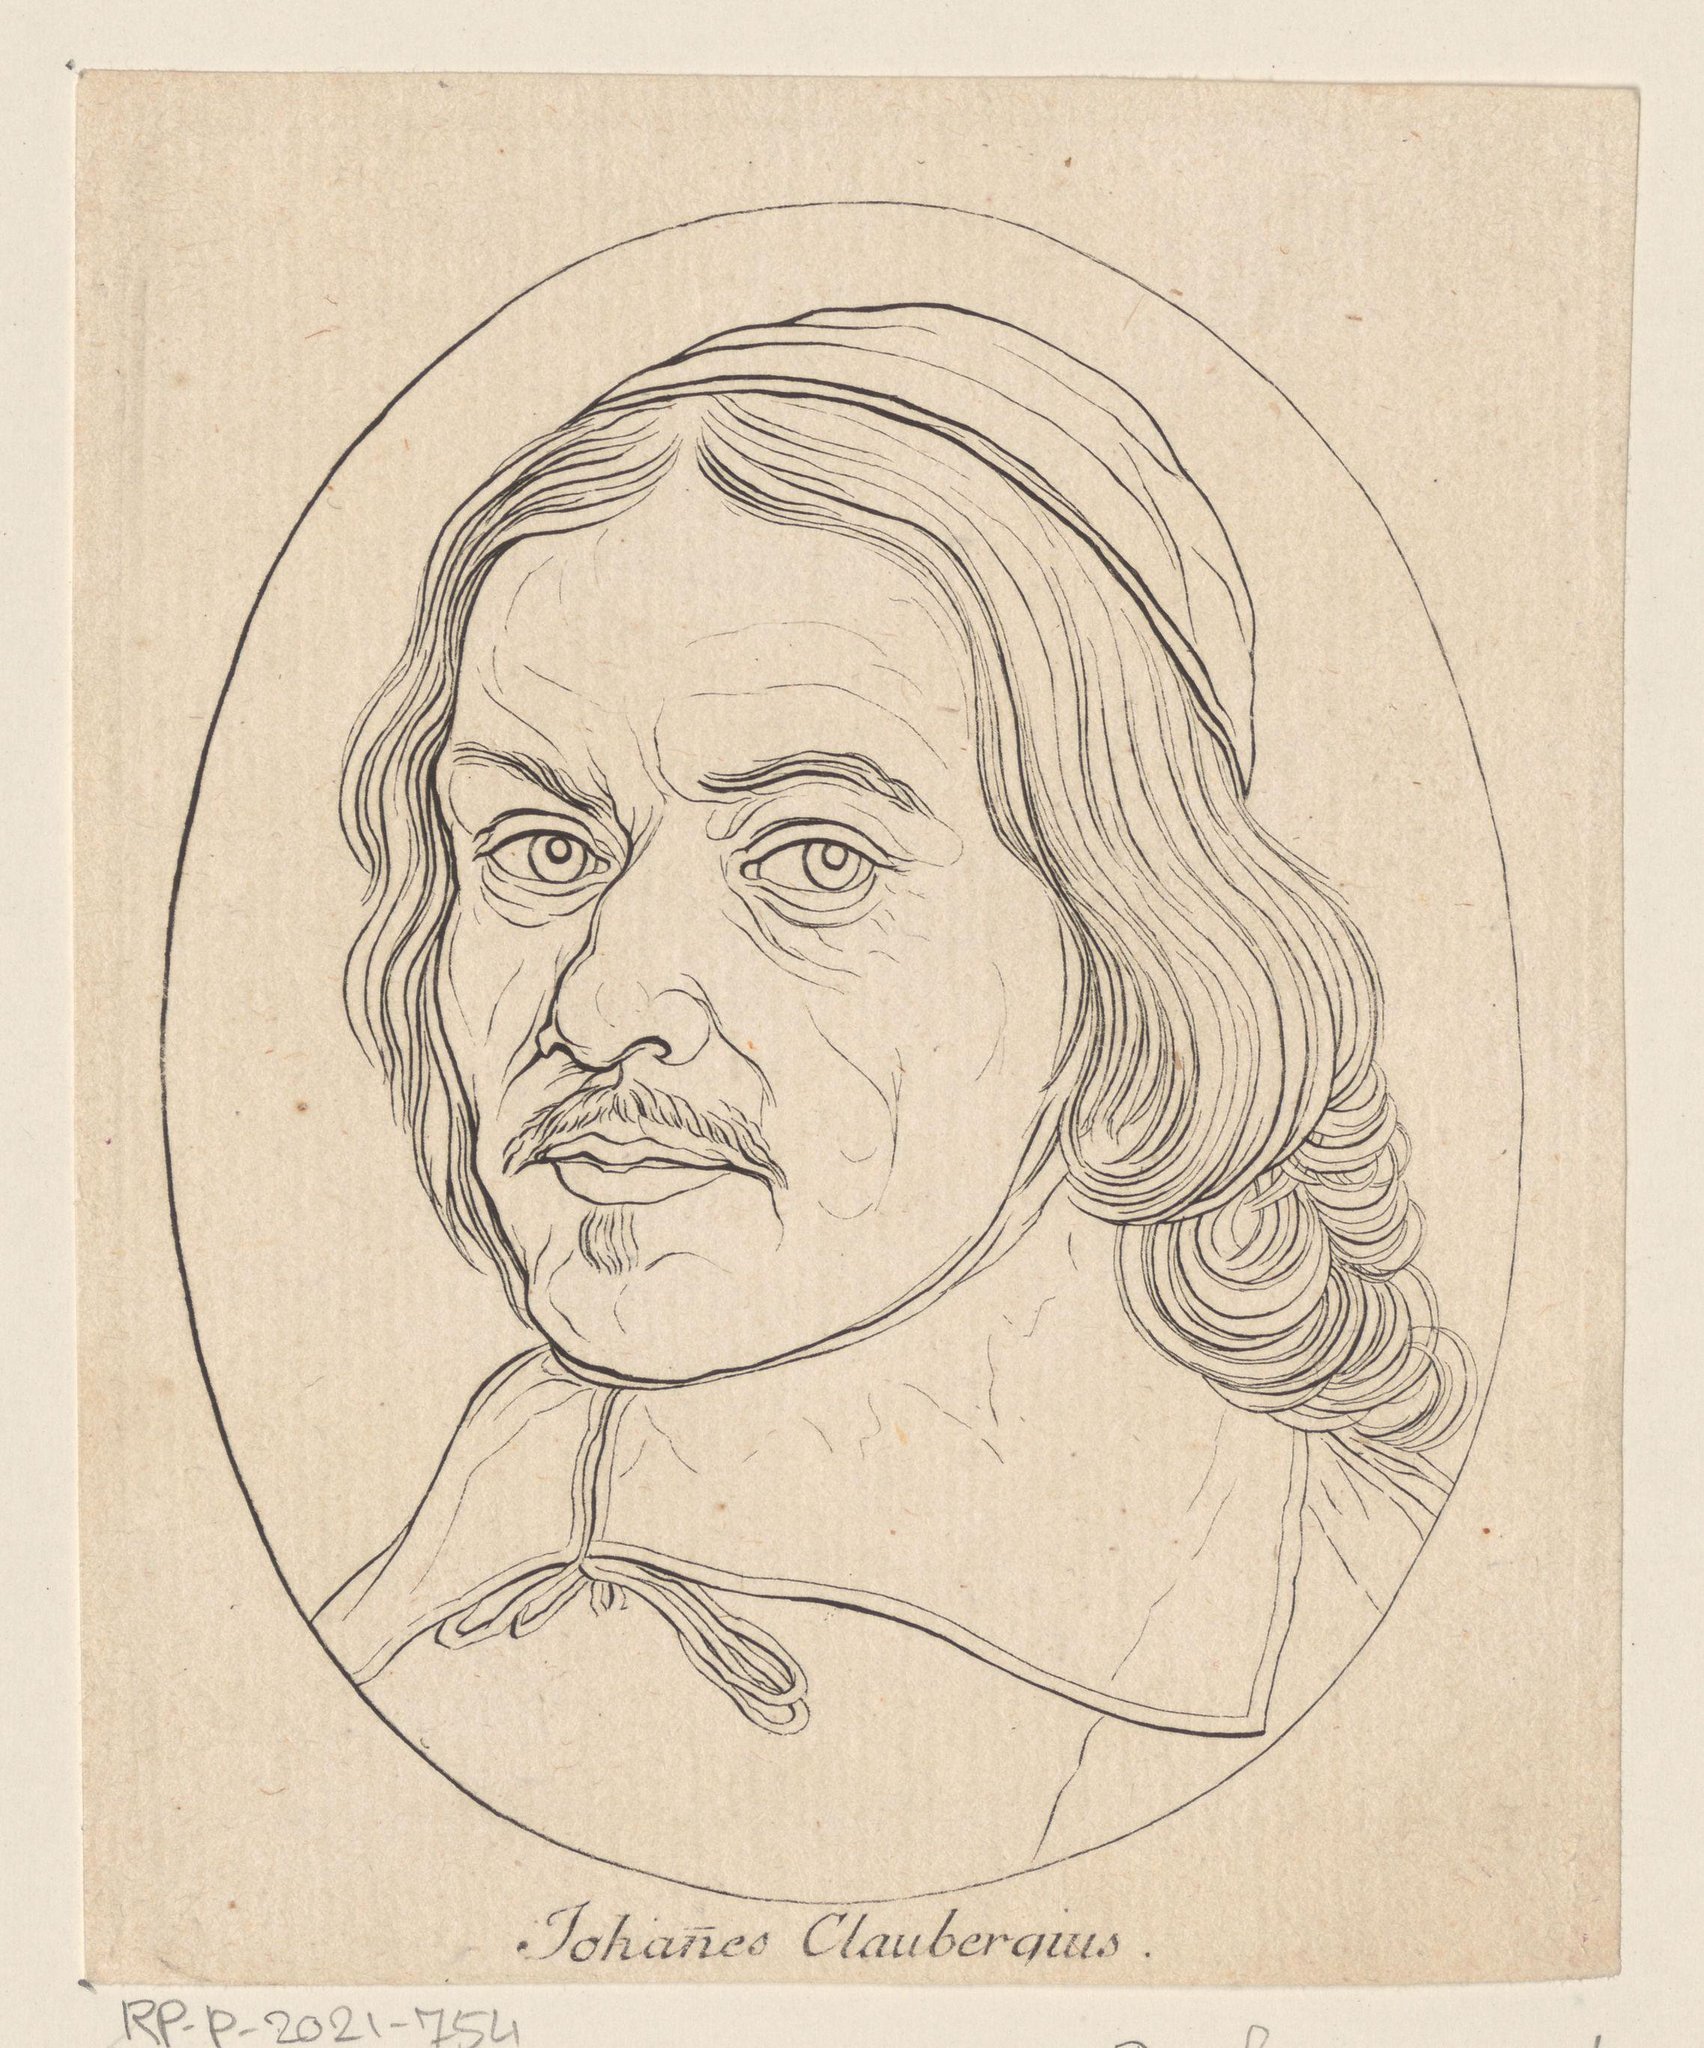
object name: print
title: Portret van Johannes Clauberg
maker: Anonymous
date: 1775-1849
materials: paper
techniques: etching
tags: solingen, historical persons